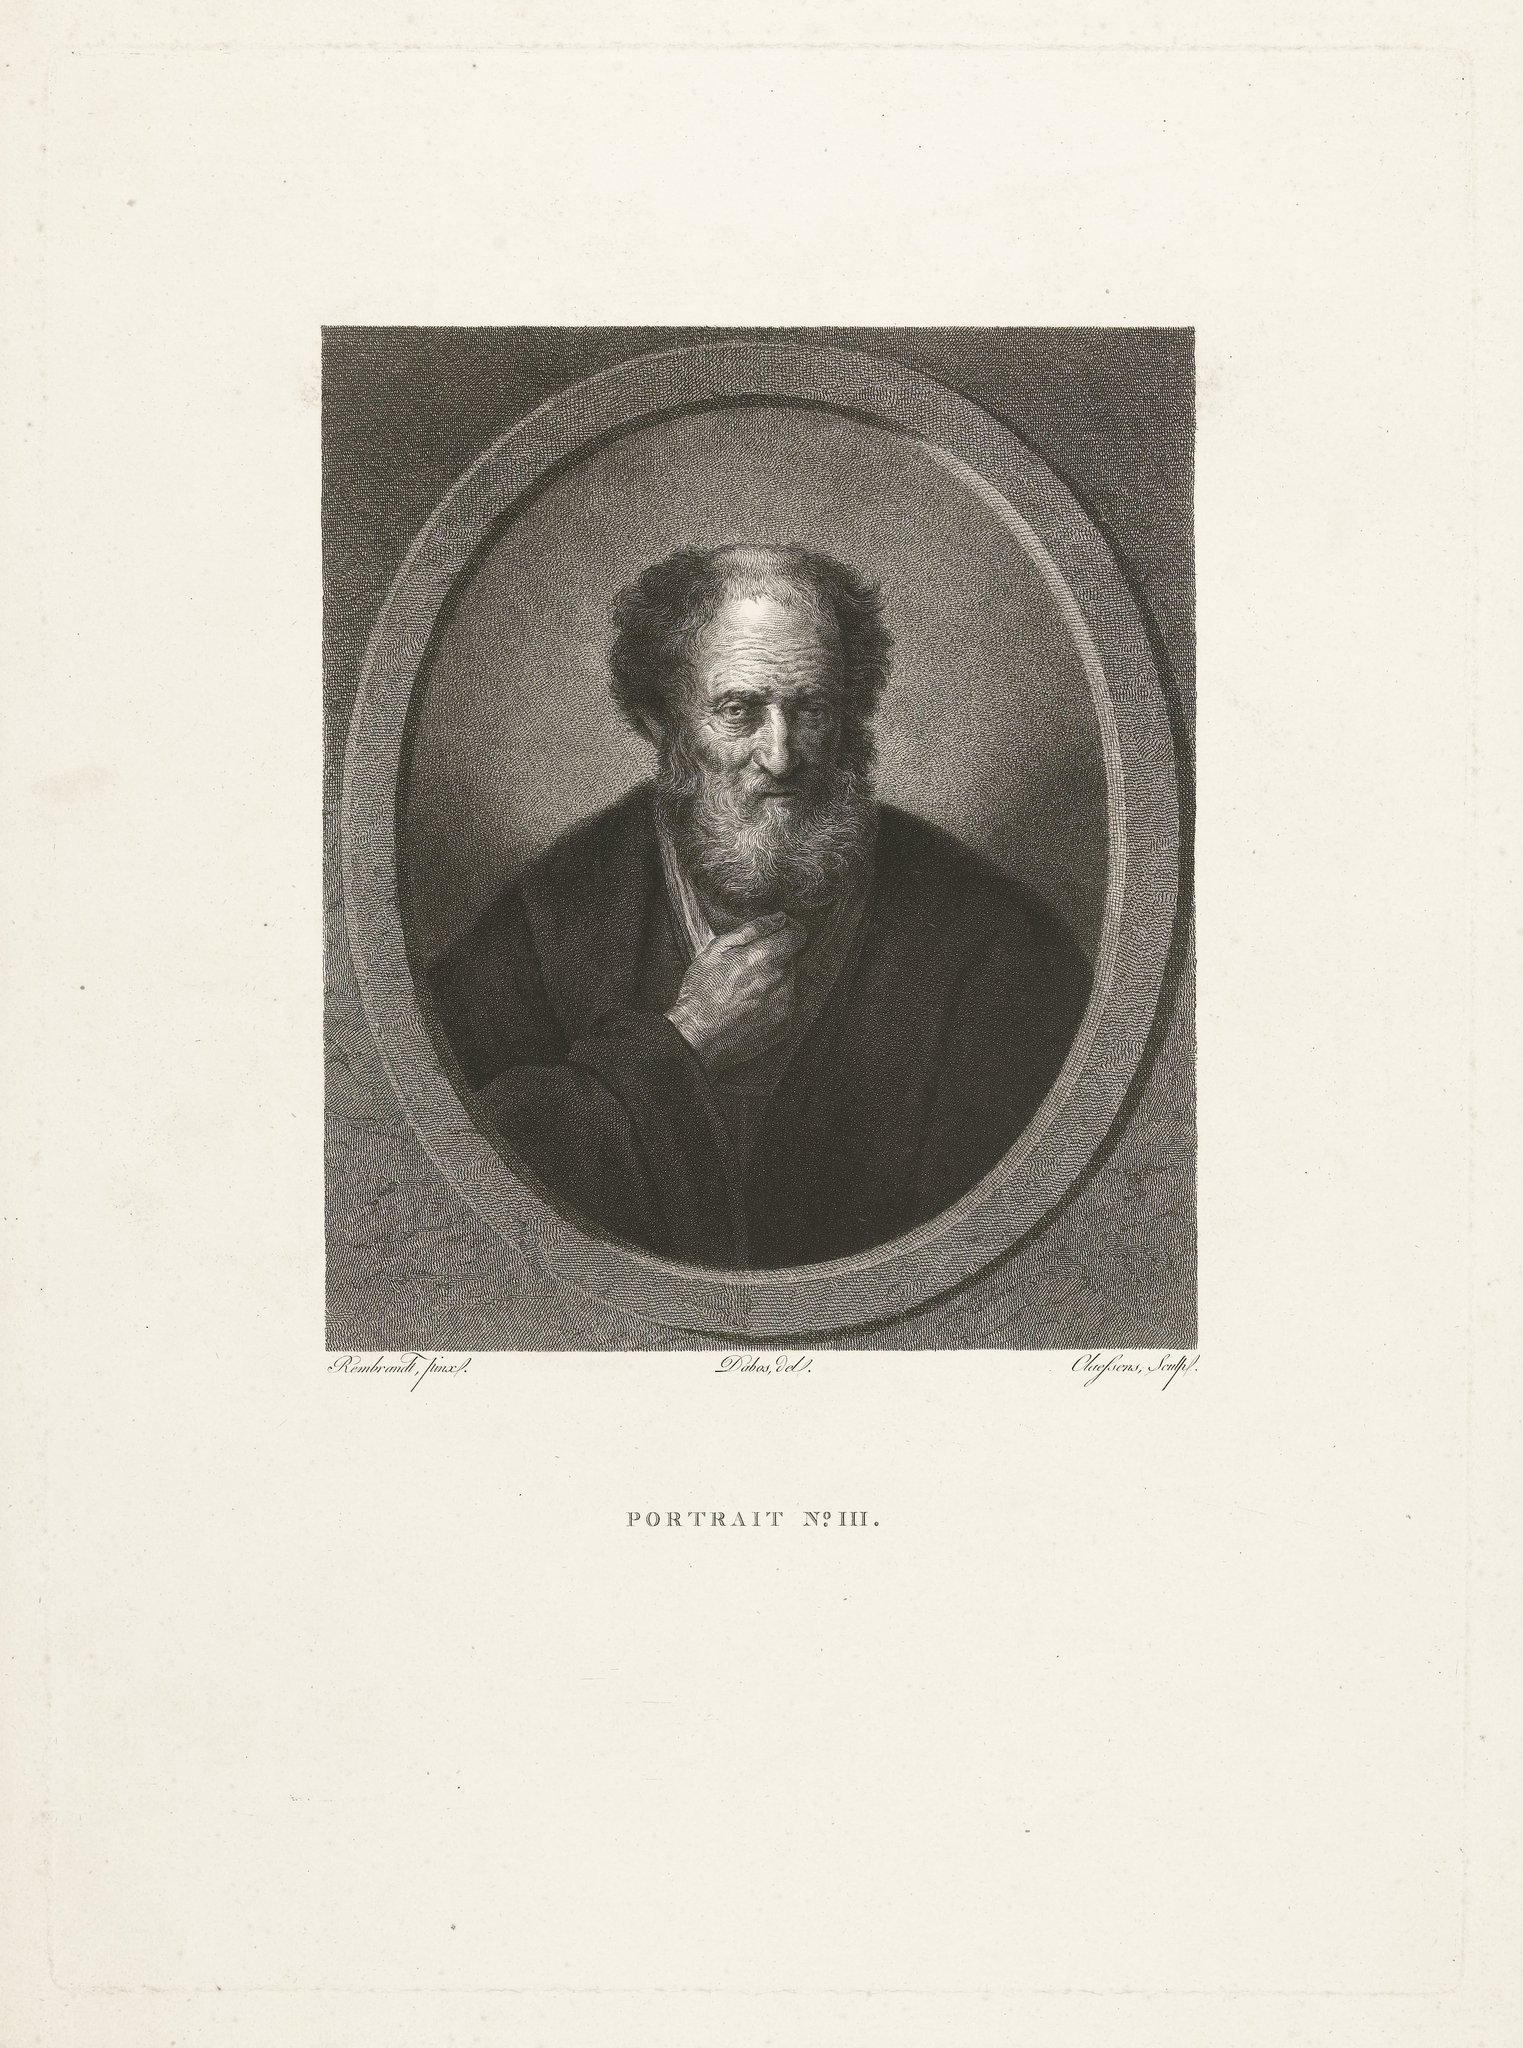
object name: print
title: Portret van een oude man met baard, en face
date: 1829-1834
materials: paper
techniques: engraving, etching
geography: paris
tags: old man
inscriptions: collector's mark: Lugt 2228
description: Gemaakt voor: Musée français : recueil des plus beaux tableaux, statues et bas-reliefs qui existaient au Louvre avant 1815, avec l'explication des sujets, et des discours historiques sur la peinture, la sculpture et la gravure. Paris: A. & W. Galignani & Londers, J.O. Robinson, [1829-39]